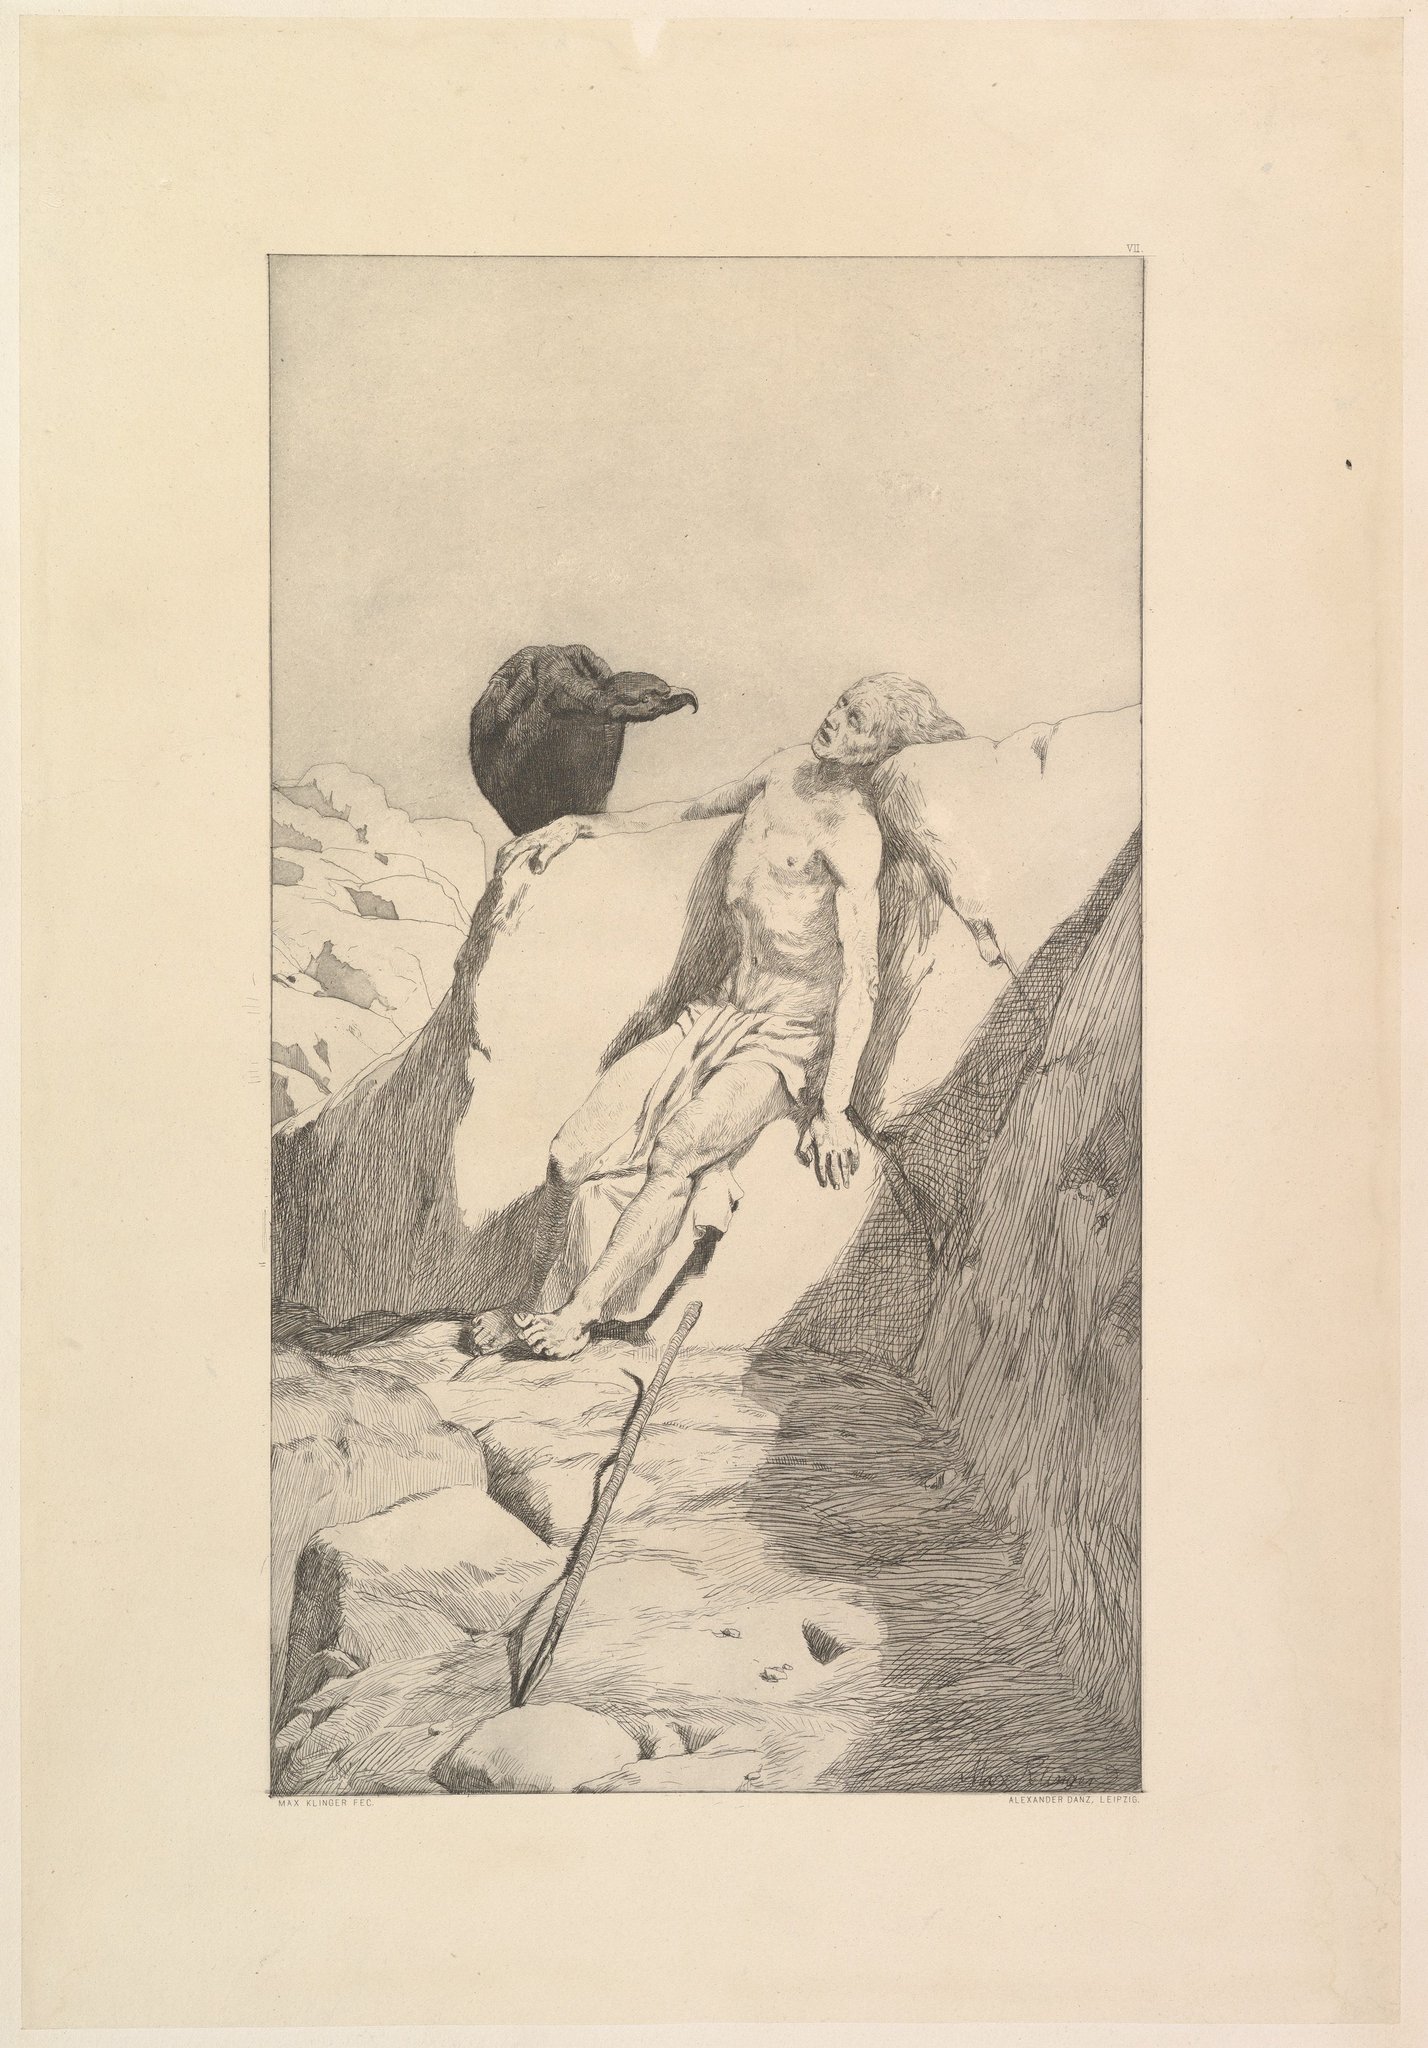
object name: print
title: Sterbender Wanderer, from the series Radierte Skizzen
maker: max klinger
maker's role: artist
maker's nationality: german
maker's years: 1857-1920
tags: birds,men